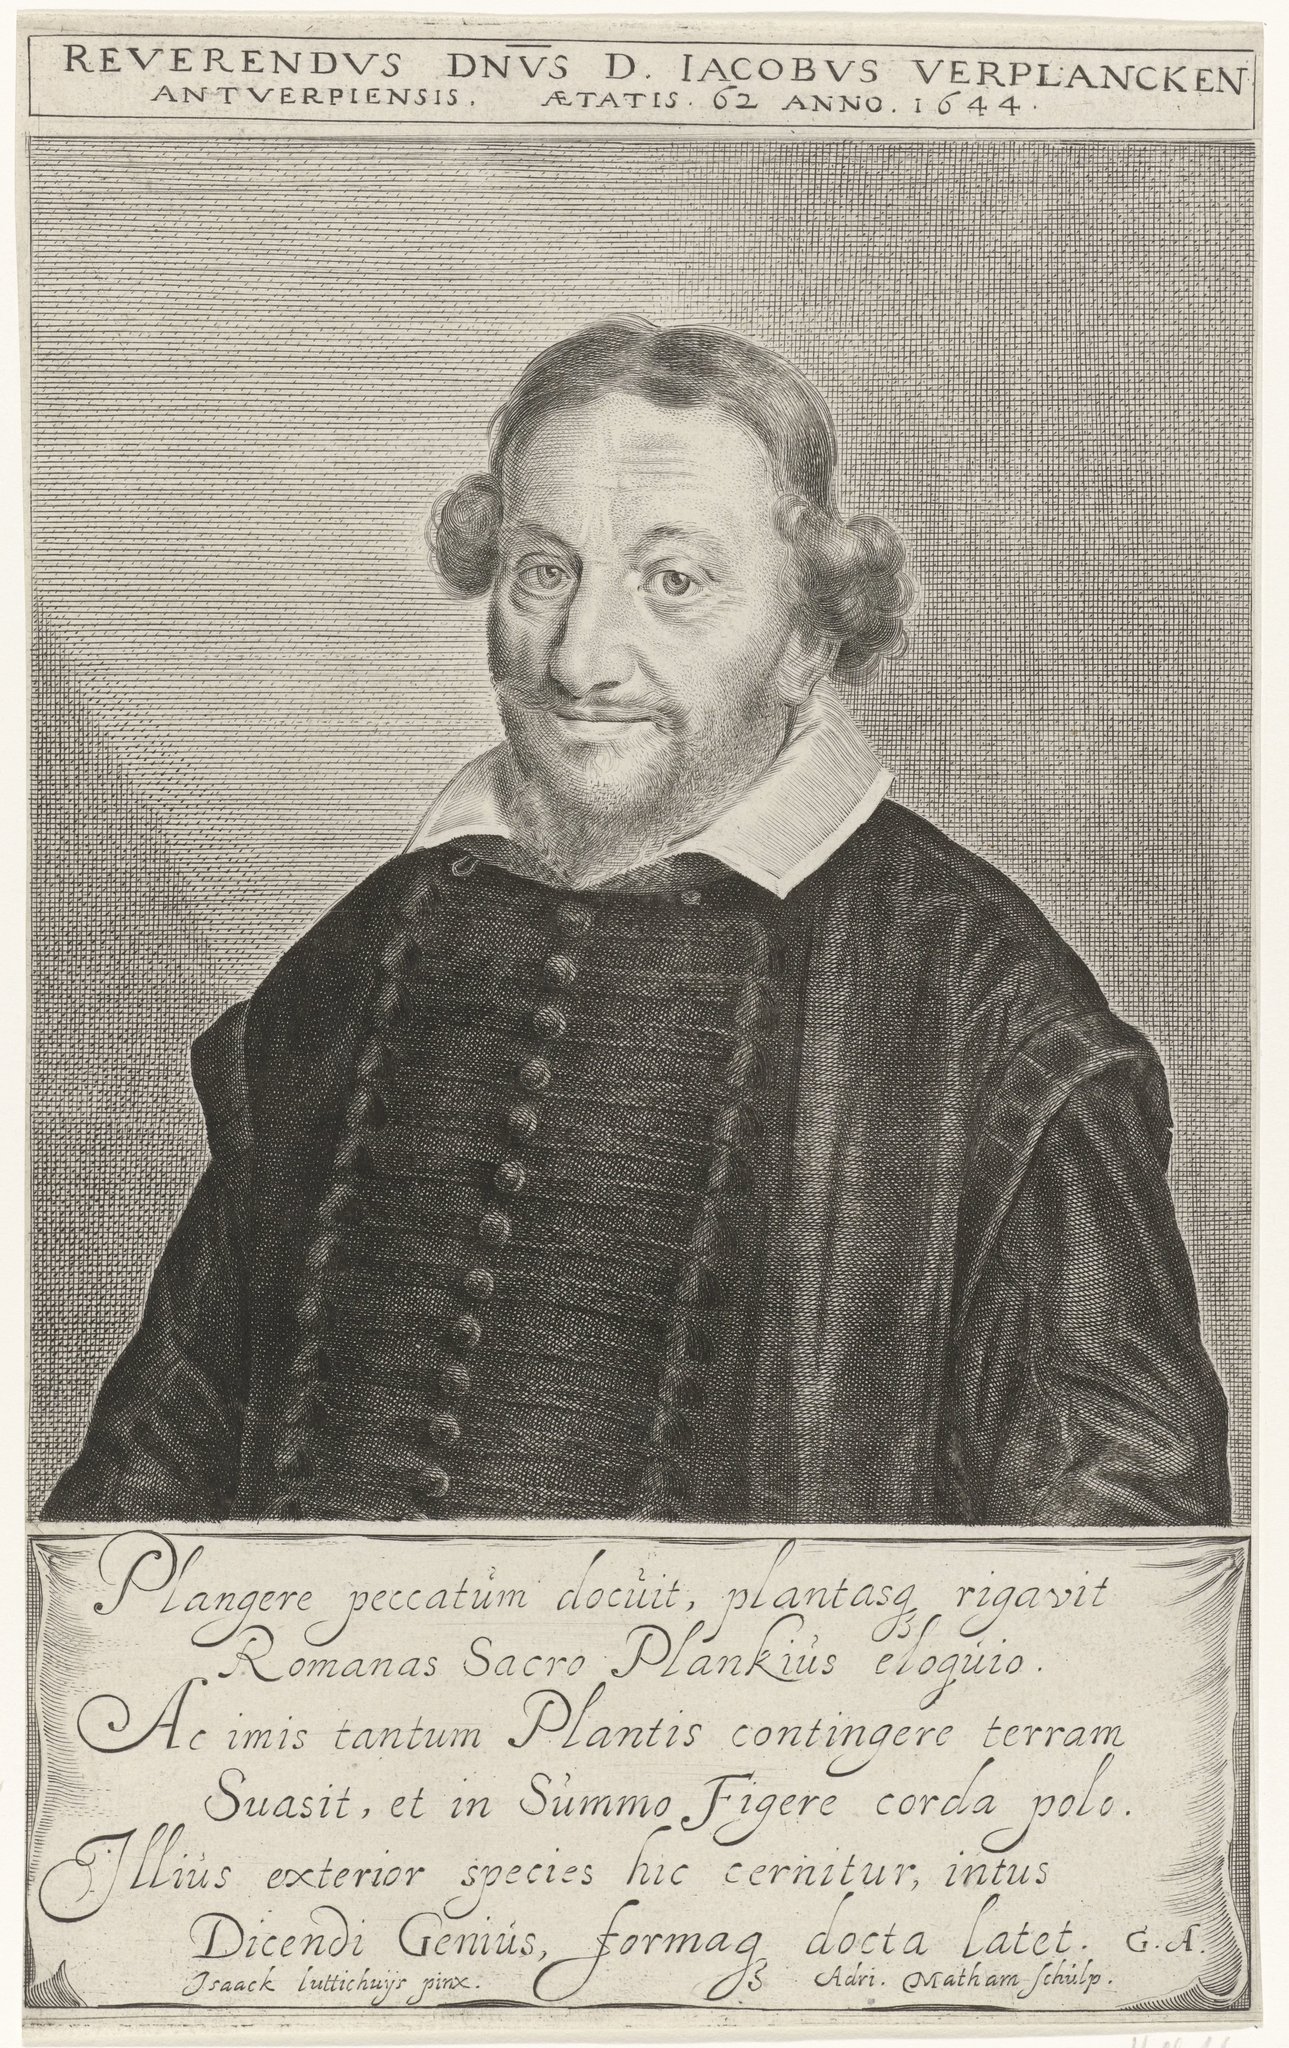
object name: print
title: Portret Jacobus Verplancken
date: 1644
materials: paper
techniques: engraving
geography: the hague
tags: theologian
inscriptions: collector's mark: Lugt 2228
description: Portret van Jacob Verplancken, theoloog in Antwerpen, op 62-jarige leeftijd.